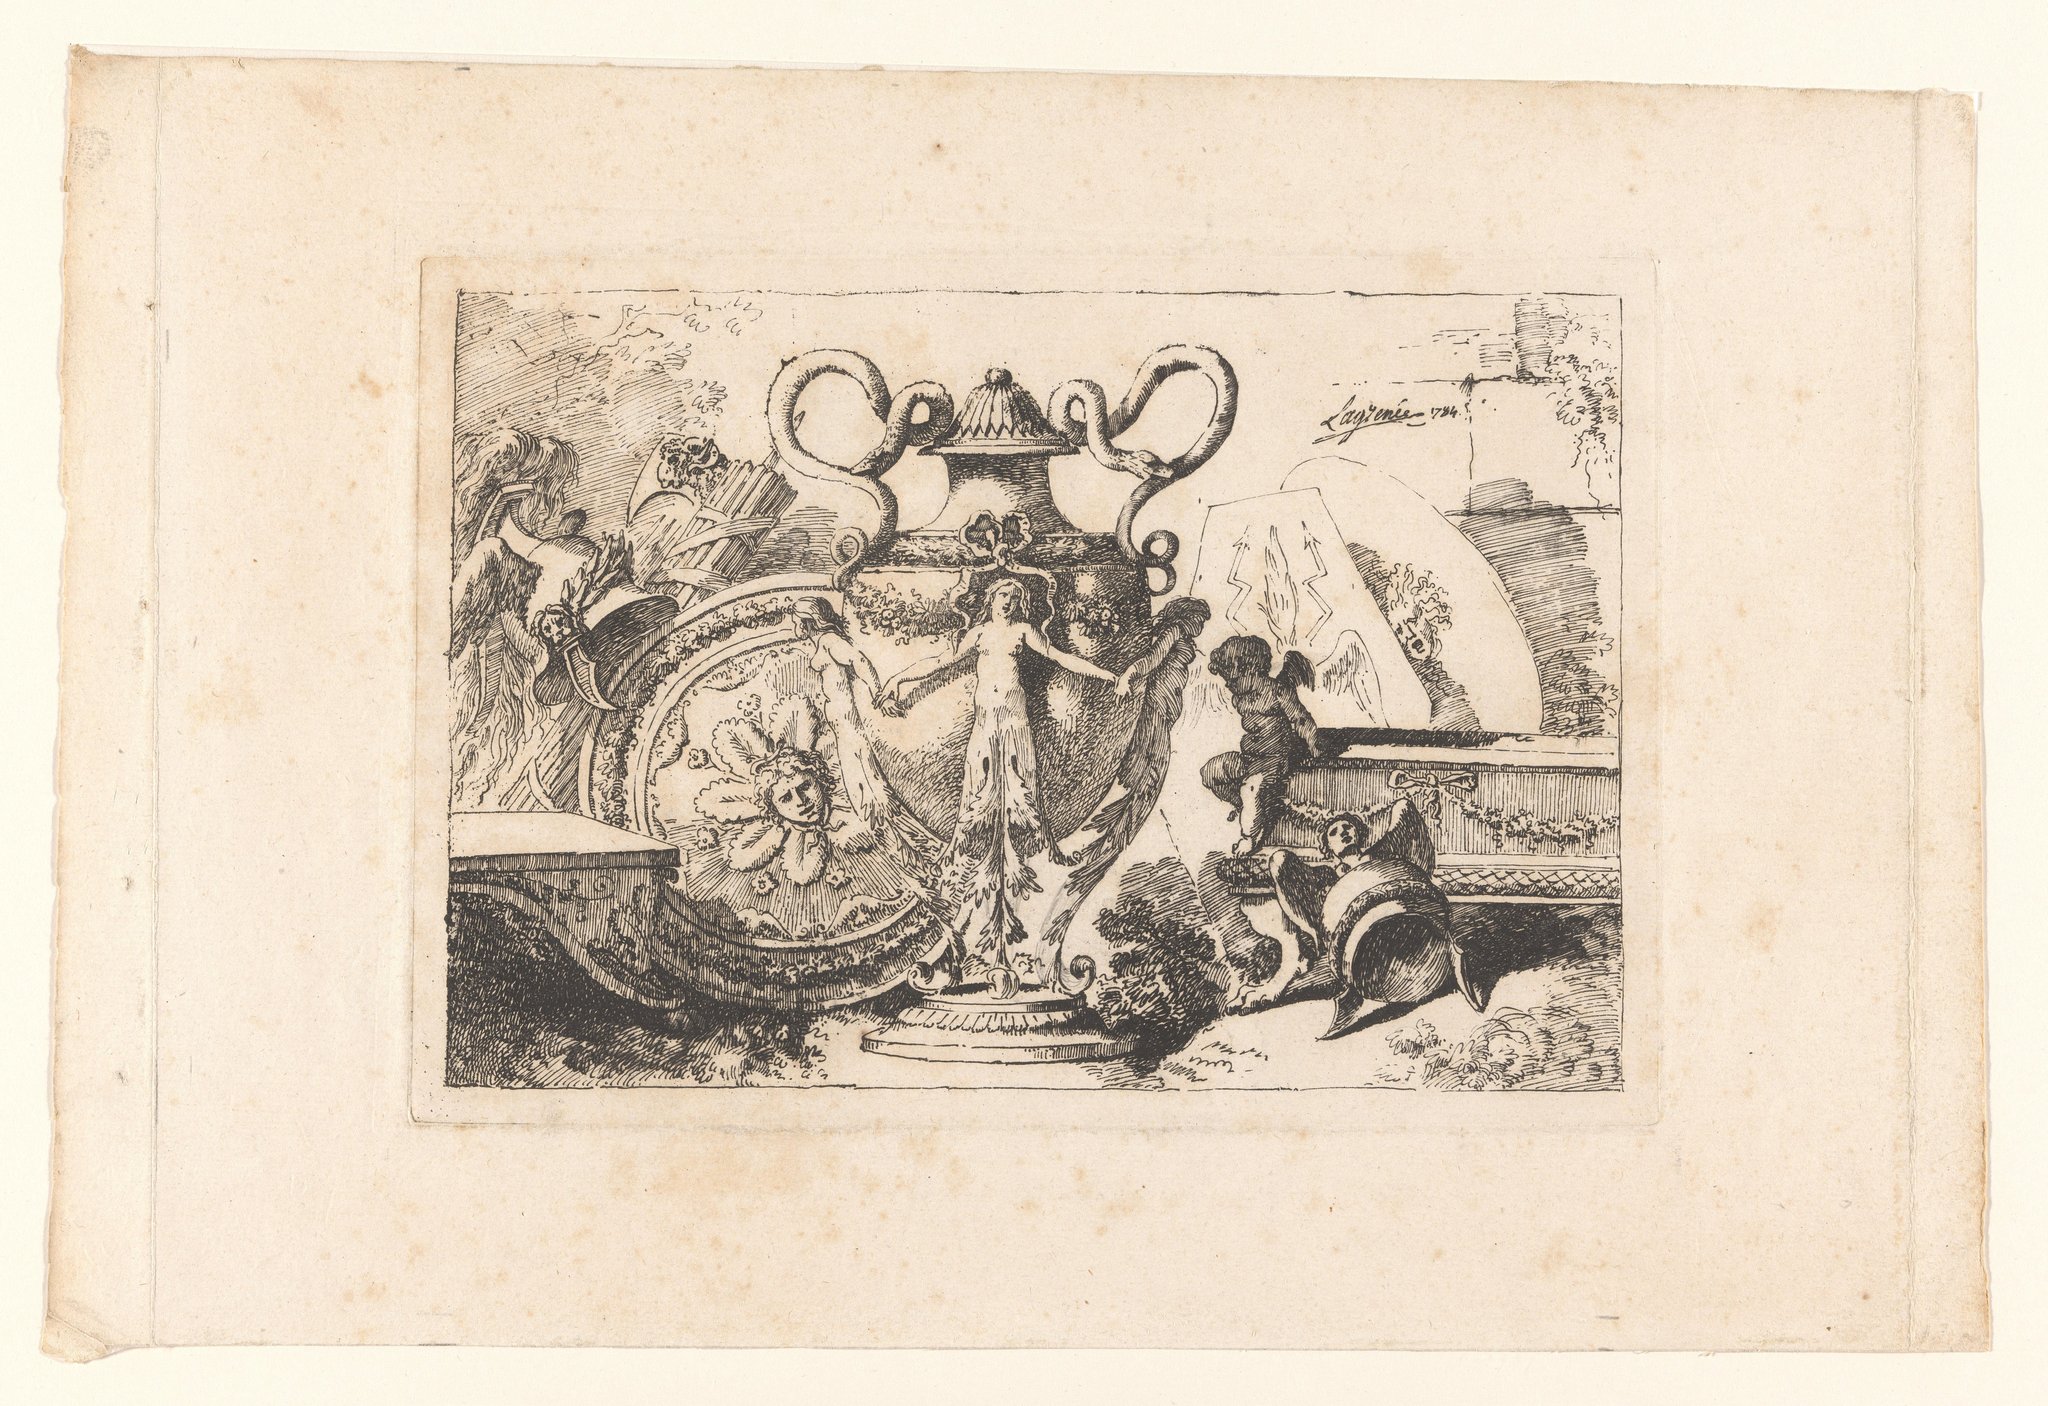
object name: ornament print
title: Antieke vaas, sarcofaag en oorlogstrofeeën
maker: jean jacques ii lagrenée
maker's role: print maker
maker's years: 1739-1821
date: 1784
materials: paper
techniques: pen, retouching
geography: paris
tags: 'tropaion', i.e. decorative ornament ~ weapons, ornament derived from objects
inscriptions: collector's mark: Lugt 2228, collector's mark: Lugt 2760